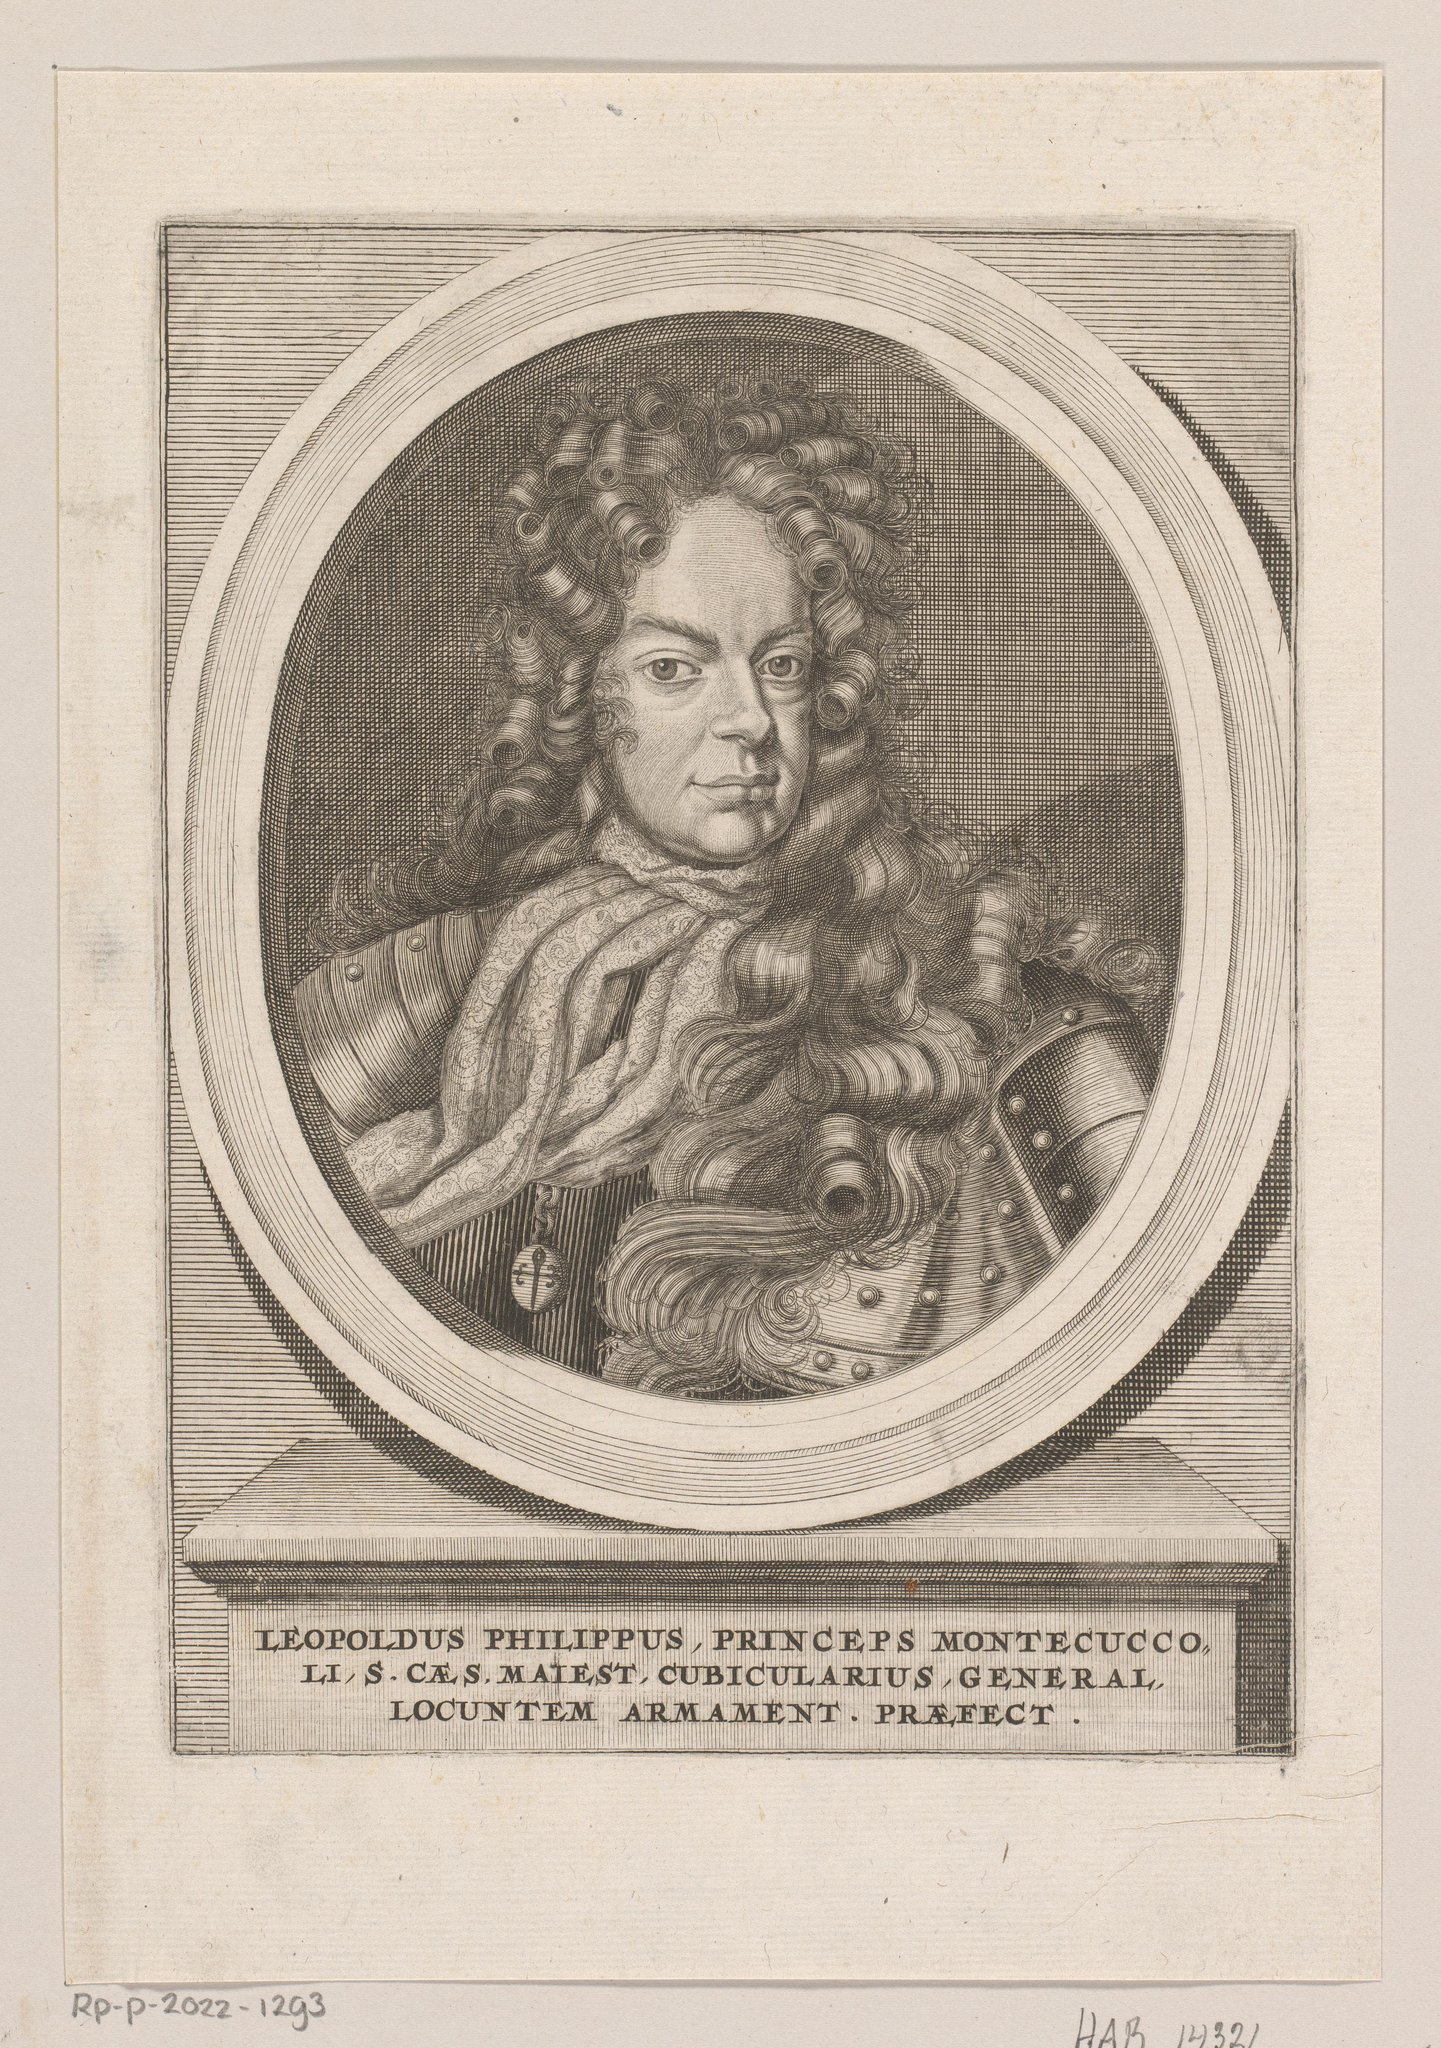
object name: book illustration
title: Portret van Leopold Philip Montecuccoli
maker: elias nessenthaler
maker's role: print maker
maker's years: 1664-1714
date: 1702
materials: paper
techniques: engraving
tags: armour, historical persons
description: Prent waarschijnlijk uit: Theatrum Europaeum (...). Frankfurt: erven Matthaus Merian, 1702, dl. 14. Mogelijk ook gebruikt in een latere druk van dit werk.